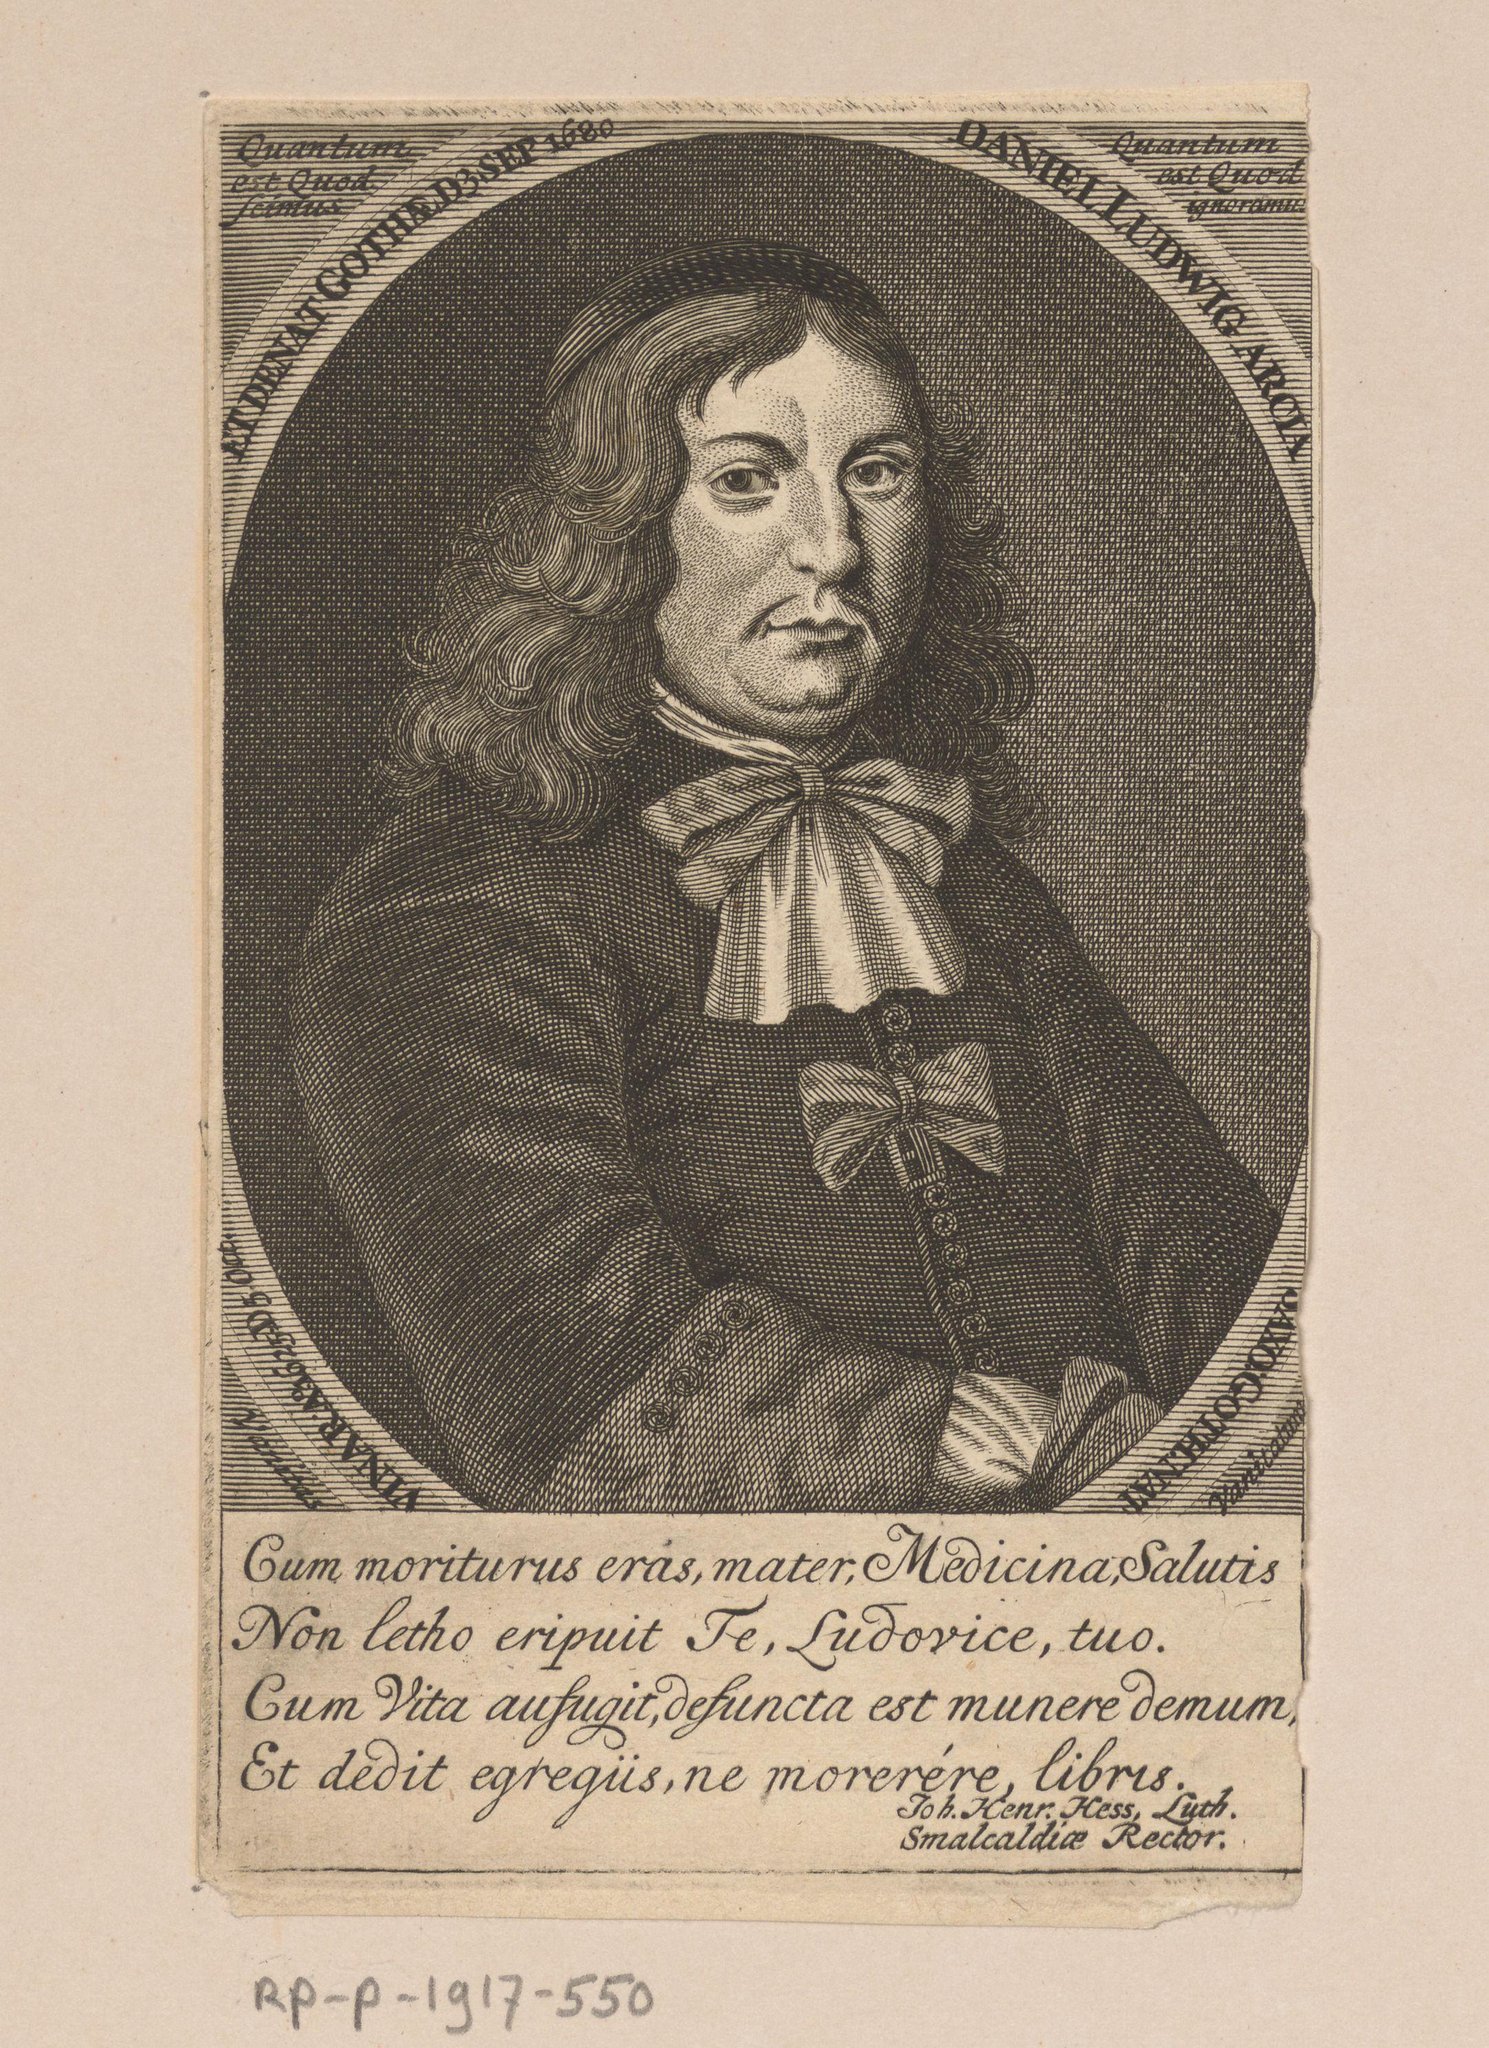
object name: print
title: Portret van Daniel Ludwig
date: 1680-1720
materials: paper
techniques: engraving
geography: germany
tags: historical persons, physician, doctor (+ portrait of scholar, scientist)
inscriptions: collector's mark: Lugt 2228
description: Met vierregelig vers in het Latijn onder het portret, en randschrift in het Latijn.